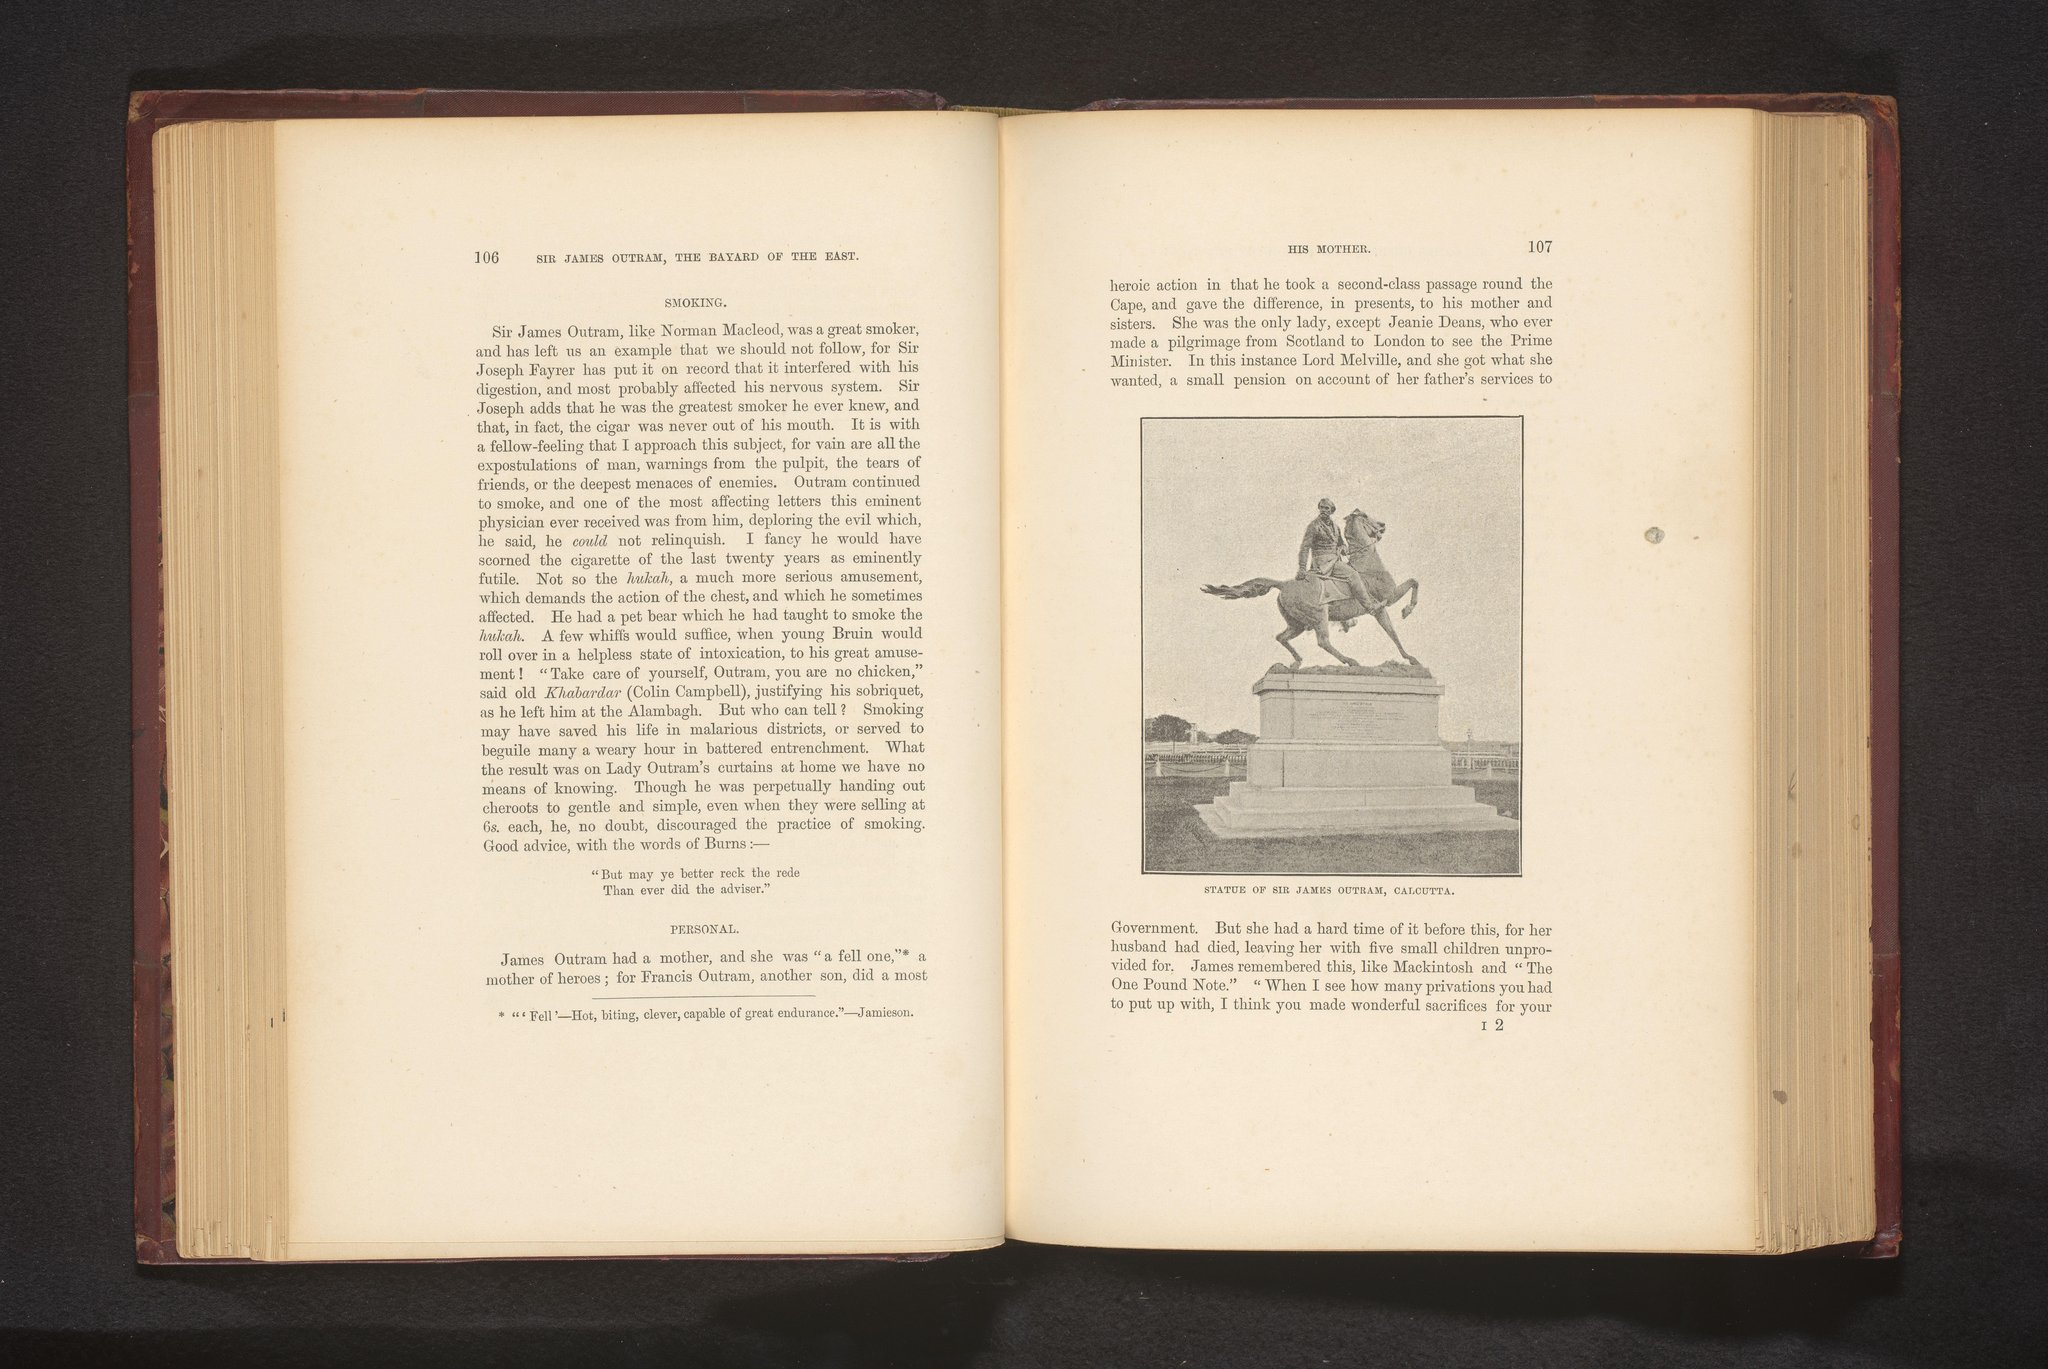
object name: page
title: Statue of Sir James Outram, Calcutta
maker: Anonymous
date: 1883-1893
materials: paper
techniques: autotype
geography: paris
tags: equestrian statue